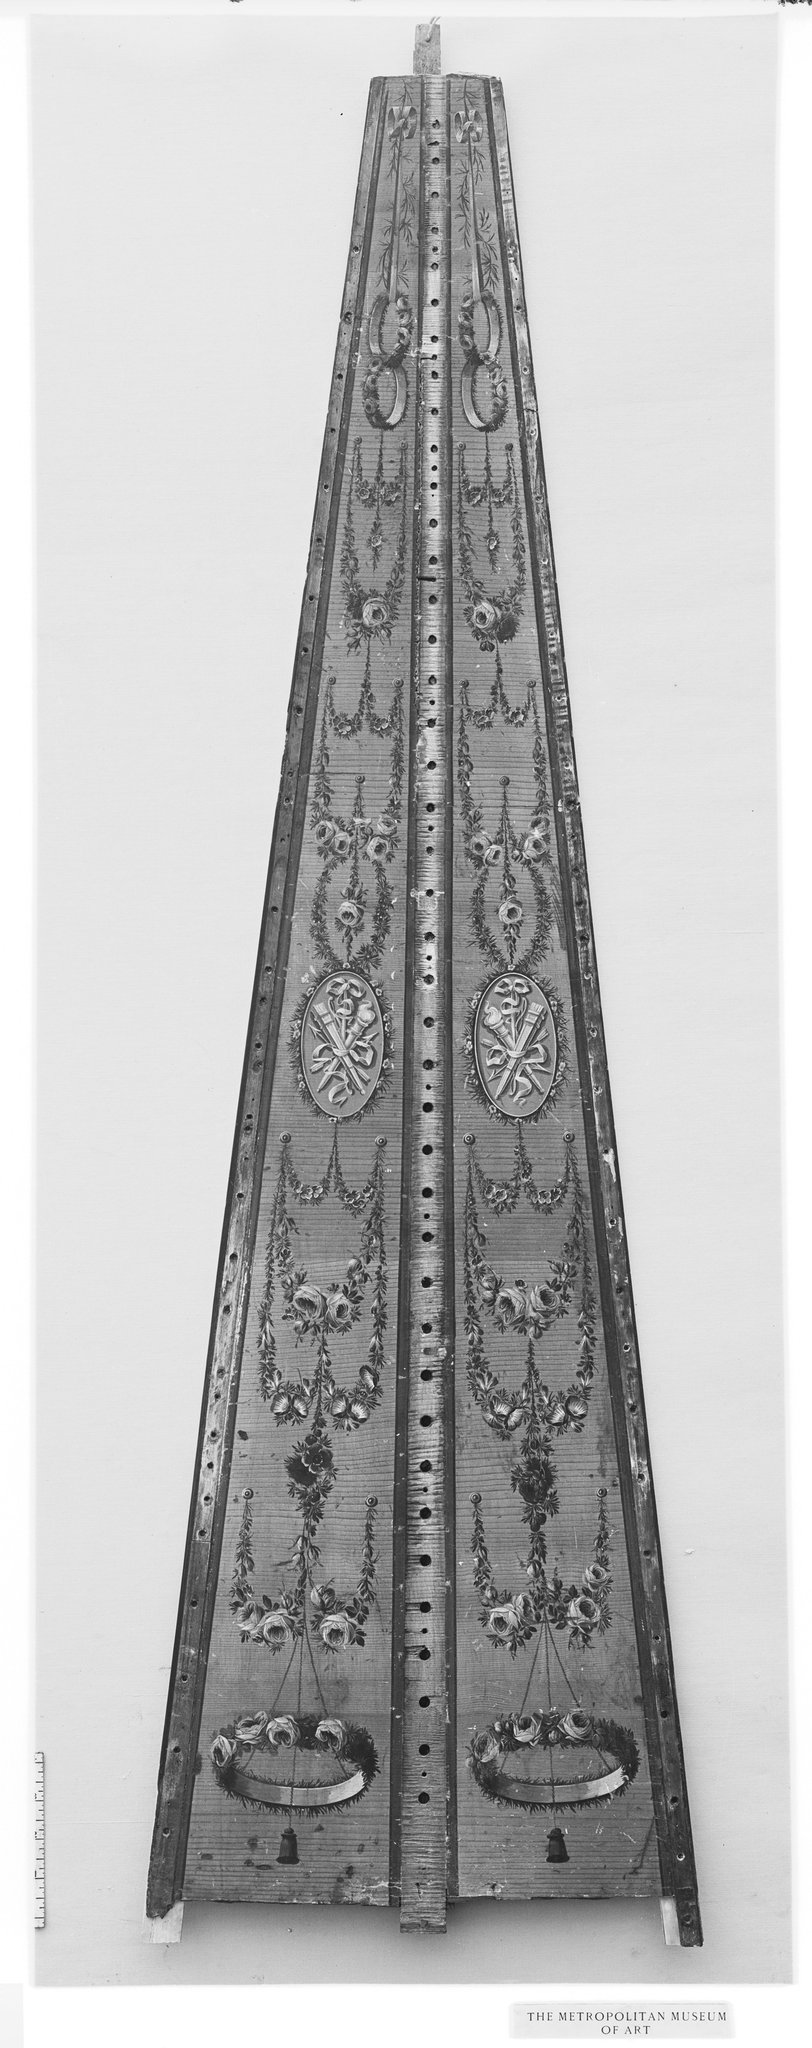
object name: harp panel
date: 1701-1800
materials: wood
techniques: painting